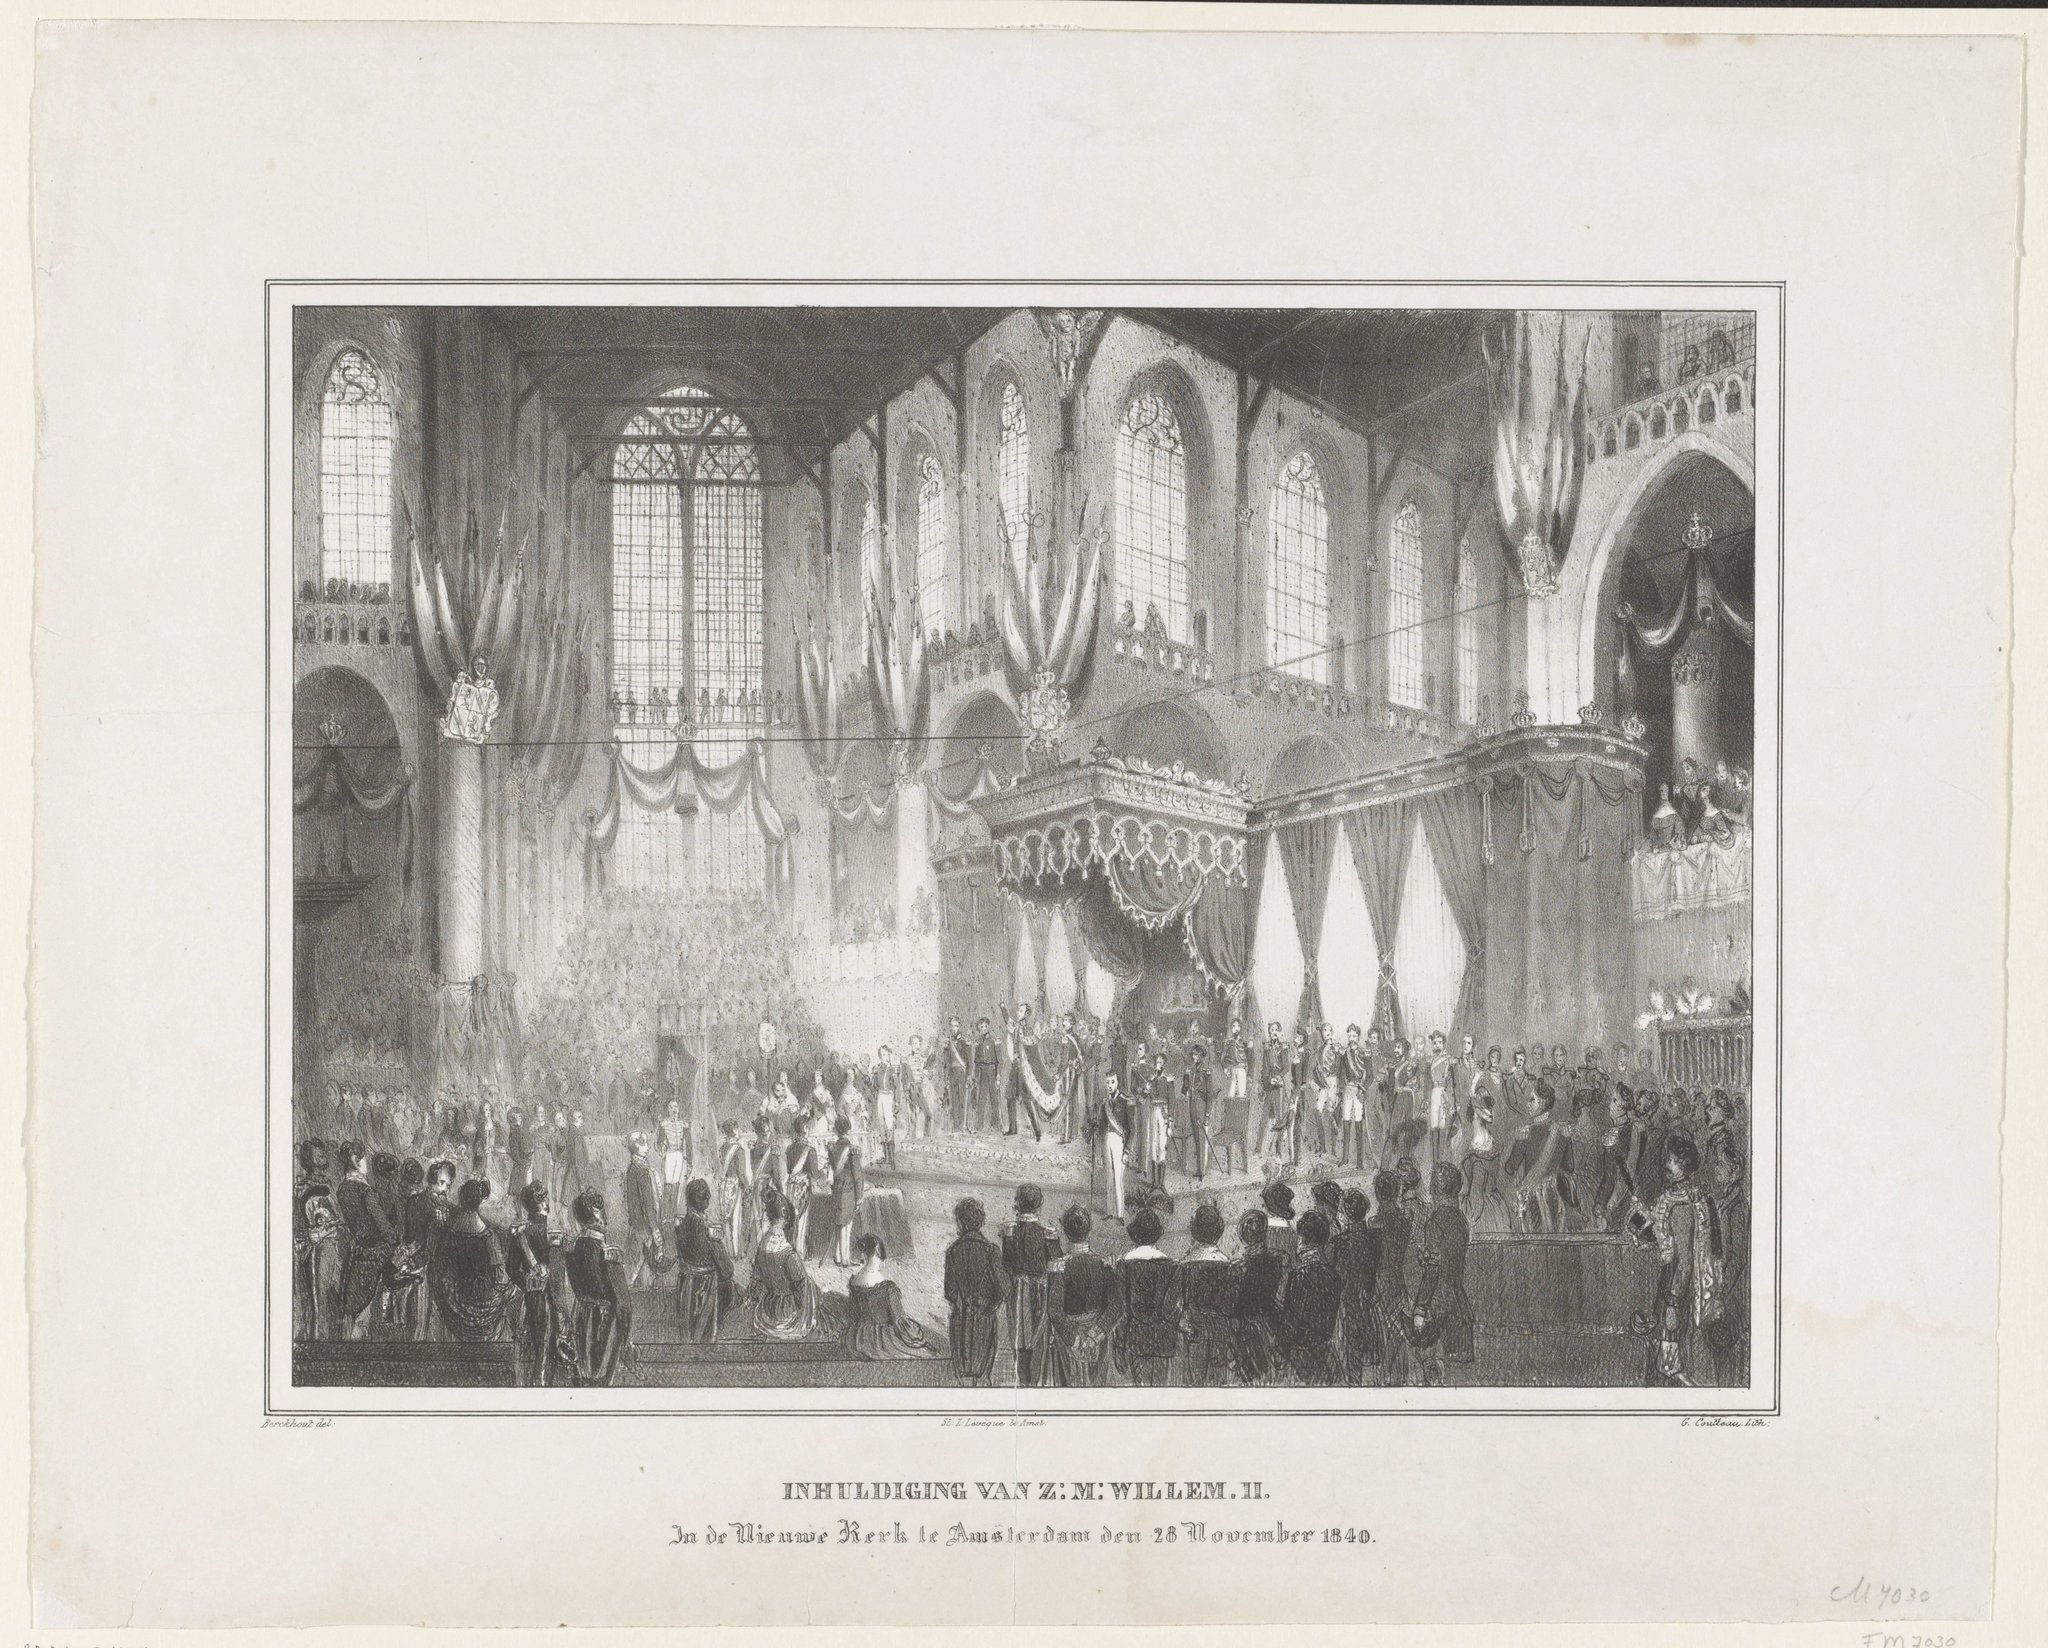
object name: print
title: Inhuldiging van Z:M: Willem. II. In de Nieuwe Kerk te Amsterdam den 28 November 1840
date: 1840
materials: paper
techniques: lithograph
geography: amsterdam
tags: the hague, william ii of the netherlands, new ruler taking the oath, amsterdam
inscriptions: collector's mark: Lugt 2228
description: Inhuldiging van koning Willem II in de Nieuwe Kerk te Amsterdam op 28 november 1840. De koning legt staande voor de troon de eed af.